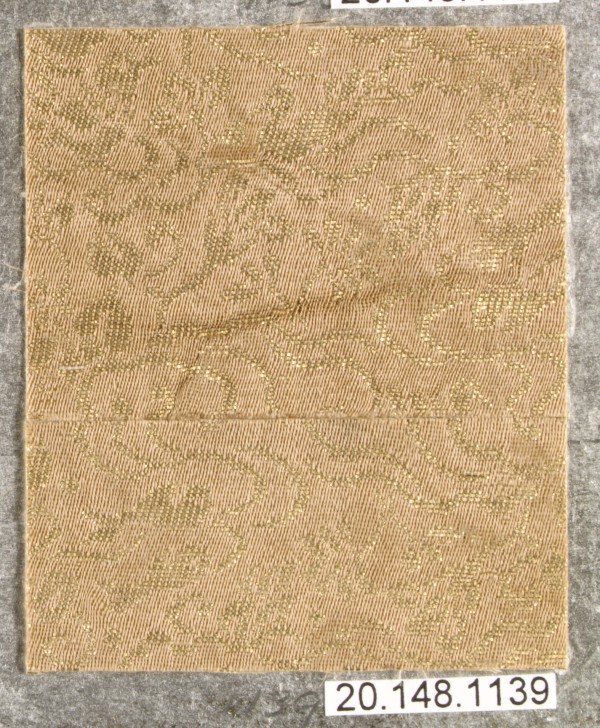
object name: piece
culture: china or japan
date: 1801-1900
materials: silk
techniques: compound weave